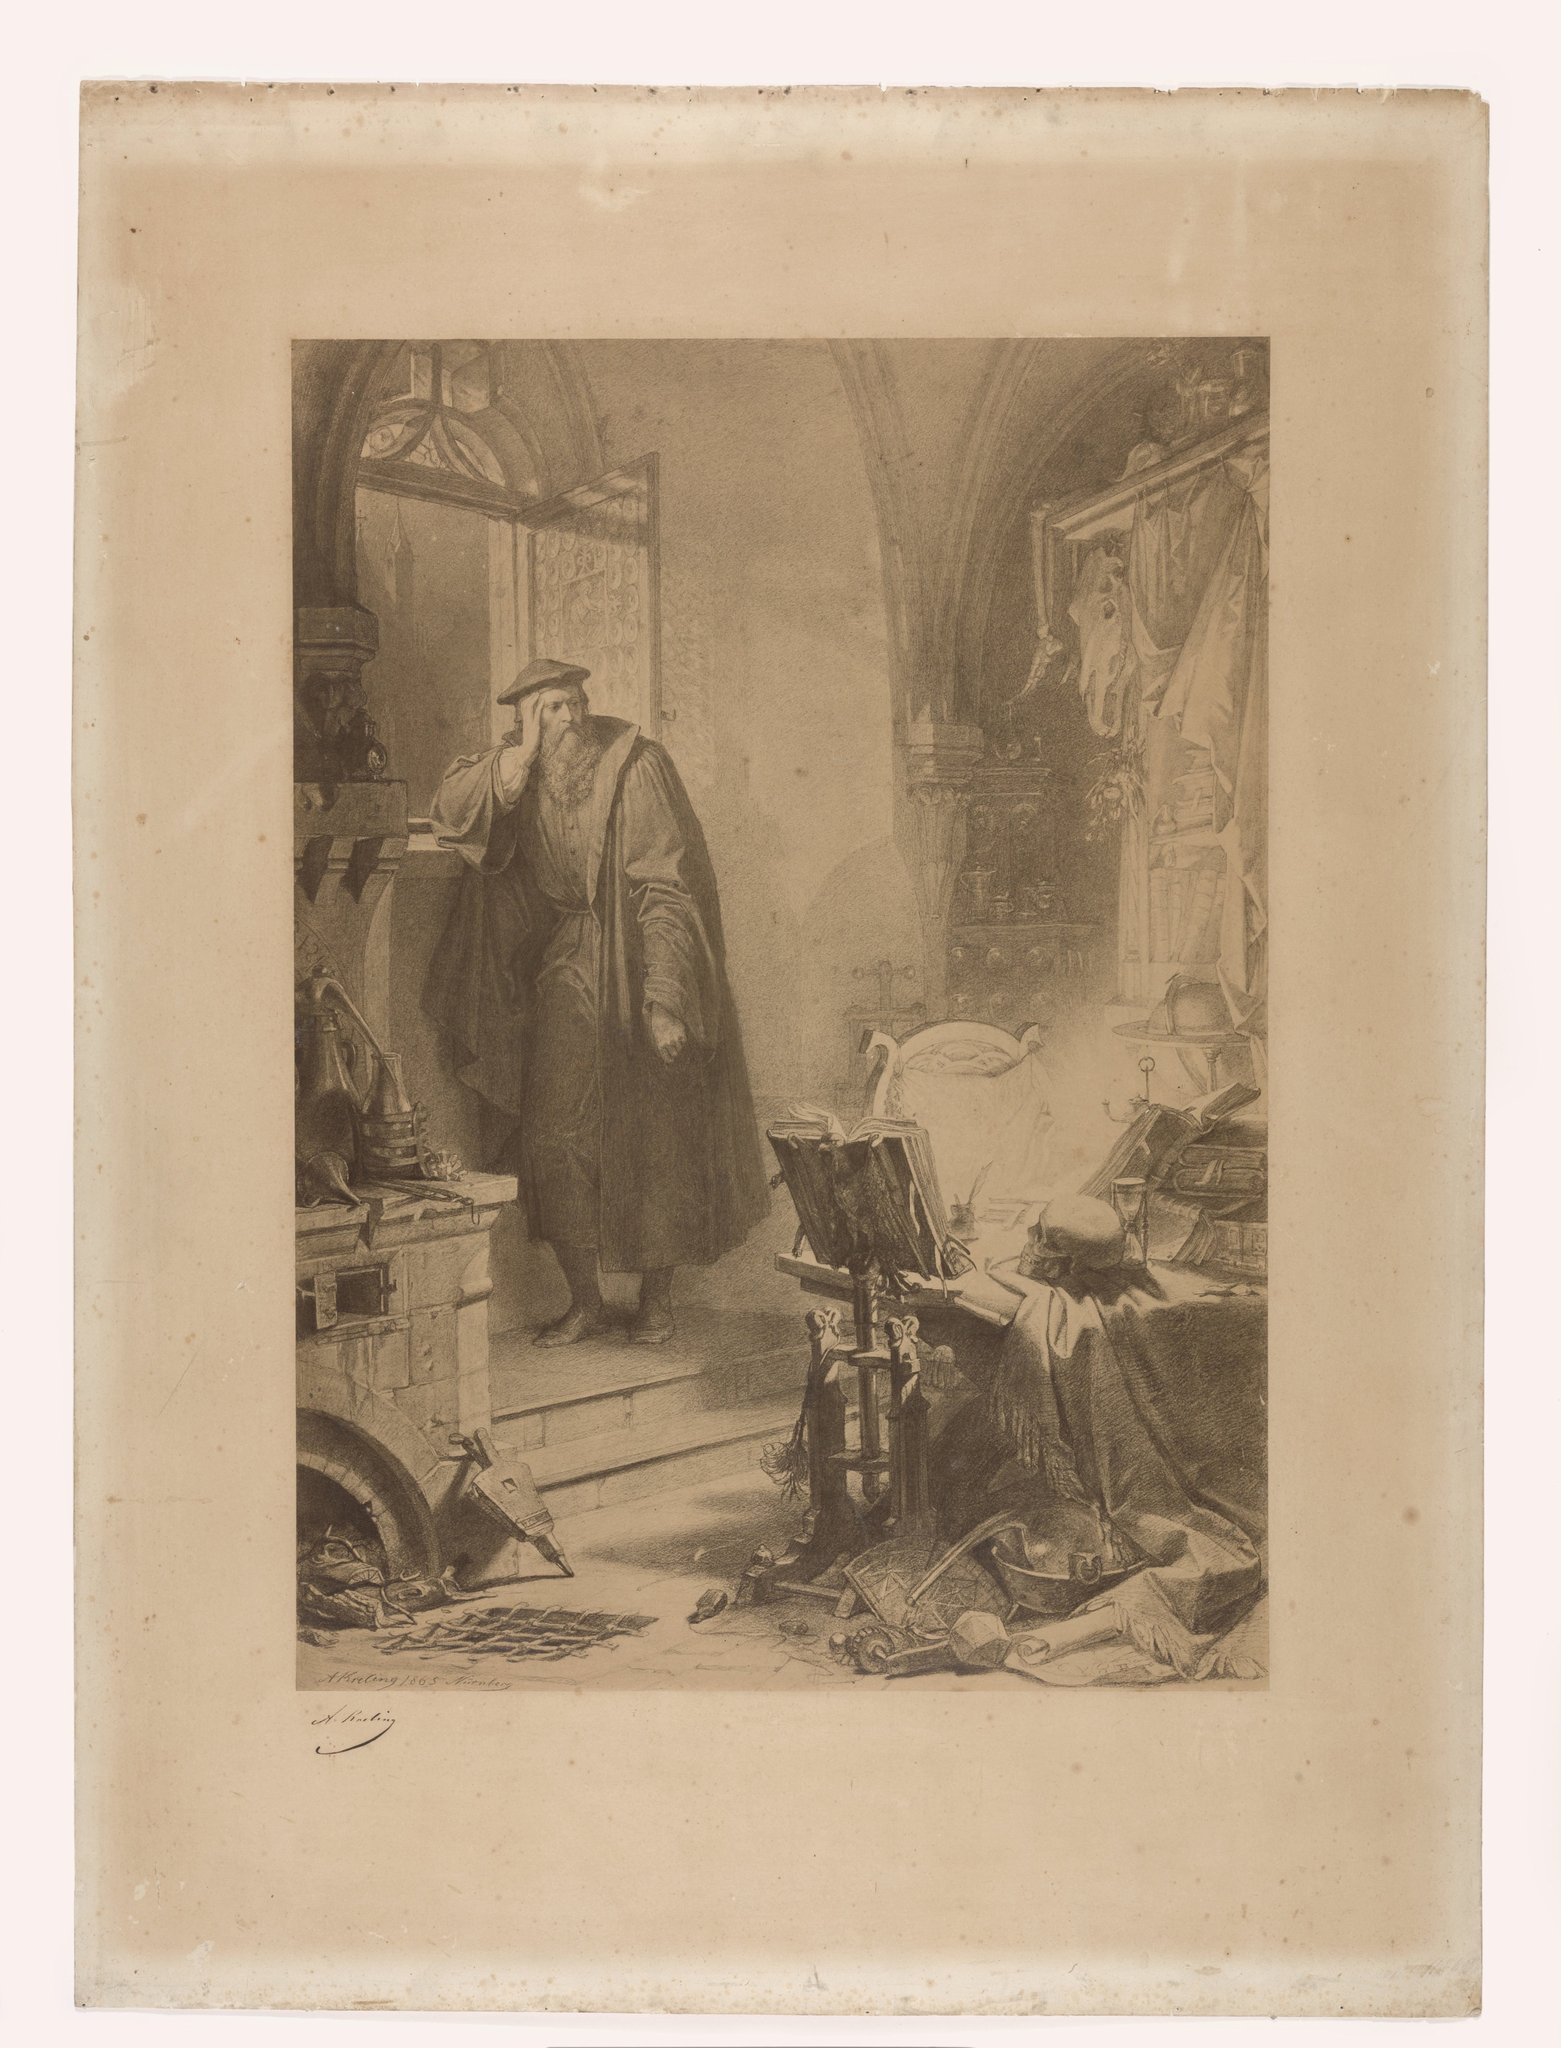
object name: photograph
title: Reproductie van een tekening van A. v. Kreling: scène uit Goethes Faust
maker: Anonymous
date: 1875-1890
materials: cardboard, paper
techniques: albumen print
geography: germany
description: Gedrukt door: Fr. Bruckmanns, Photographische Anstalt, München.